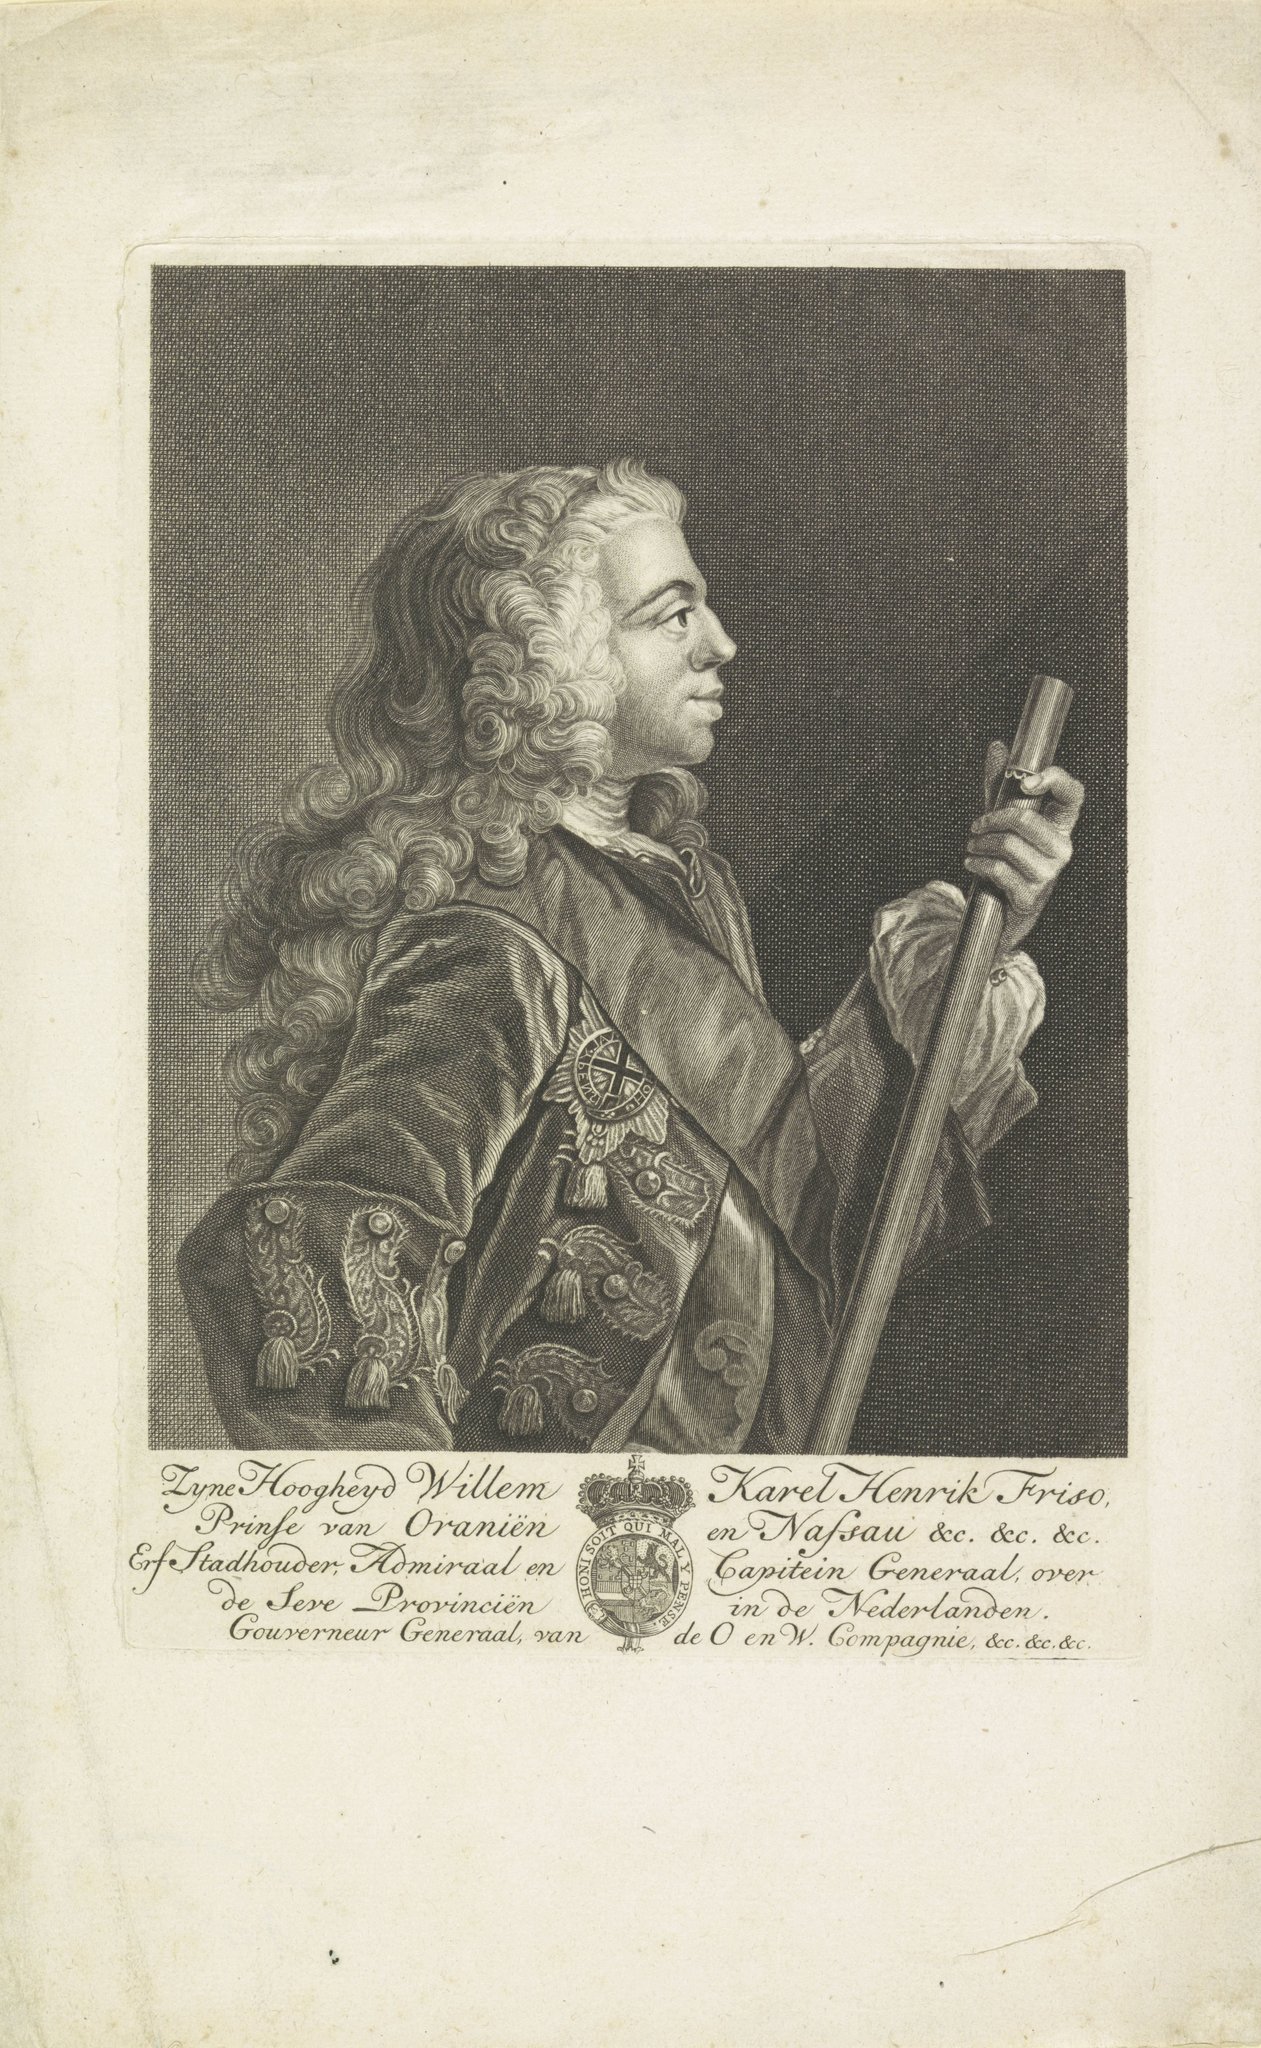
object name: print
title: Portret van Willem IV, prins van Oranje-Nassau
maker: philippus endlich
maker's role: draughtsman, print maker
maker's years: 1700-1748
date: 1747-1799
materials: paper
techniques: engraving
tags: the hague, willem iv (prins van oranje-nassau), knighthood order (garter) - insignia of a knighthood order, e.g.: badge, chain, historical persons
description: Portret van Willem IV. In zijn linkerhand een commandostaf. Midden onder zijn wapen met een kroon, gedecoreerd met de Kousenband en het devies van de Orde van de Kousenband. In de ondermarge zijn naam en titels.